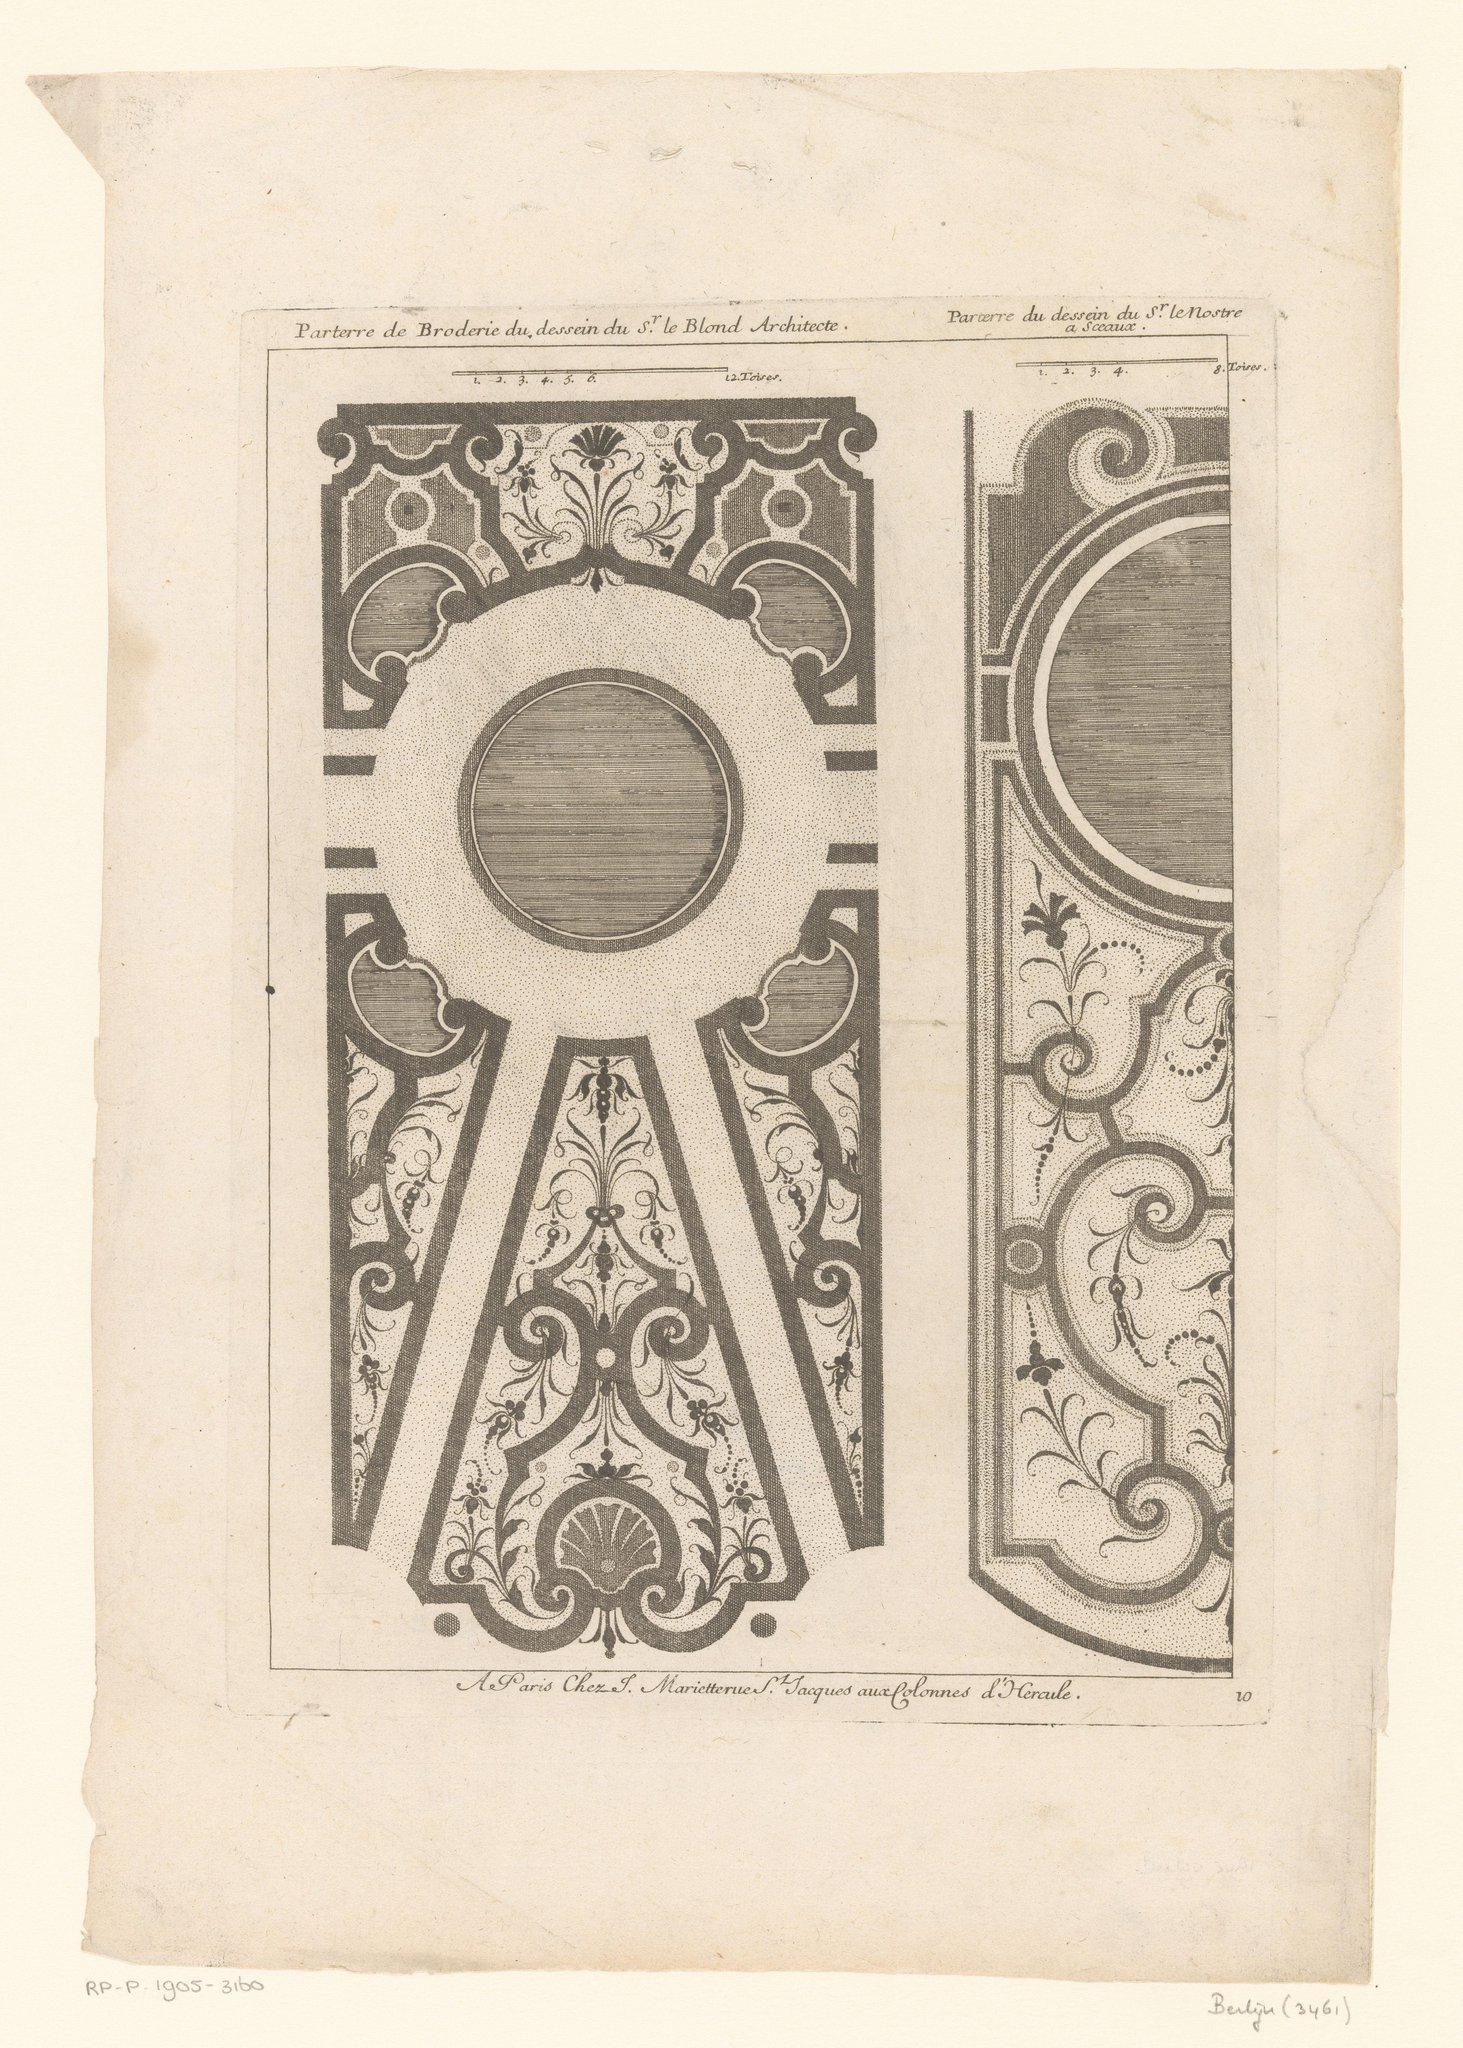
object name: print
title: Twee parterres met vijvers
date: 1691-1742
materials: paper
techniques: etching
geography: paris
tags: plan, map of garden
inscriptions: inscription: ‘2a / 3-12-76’, collector's mark: Lugt 2228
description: Links een tuinontwerp met vier parterres met twee paden en in het midden een ronde vijver. Rechts een parterre met aan de bovenzijde een ronde vijver.